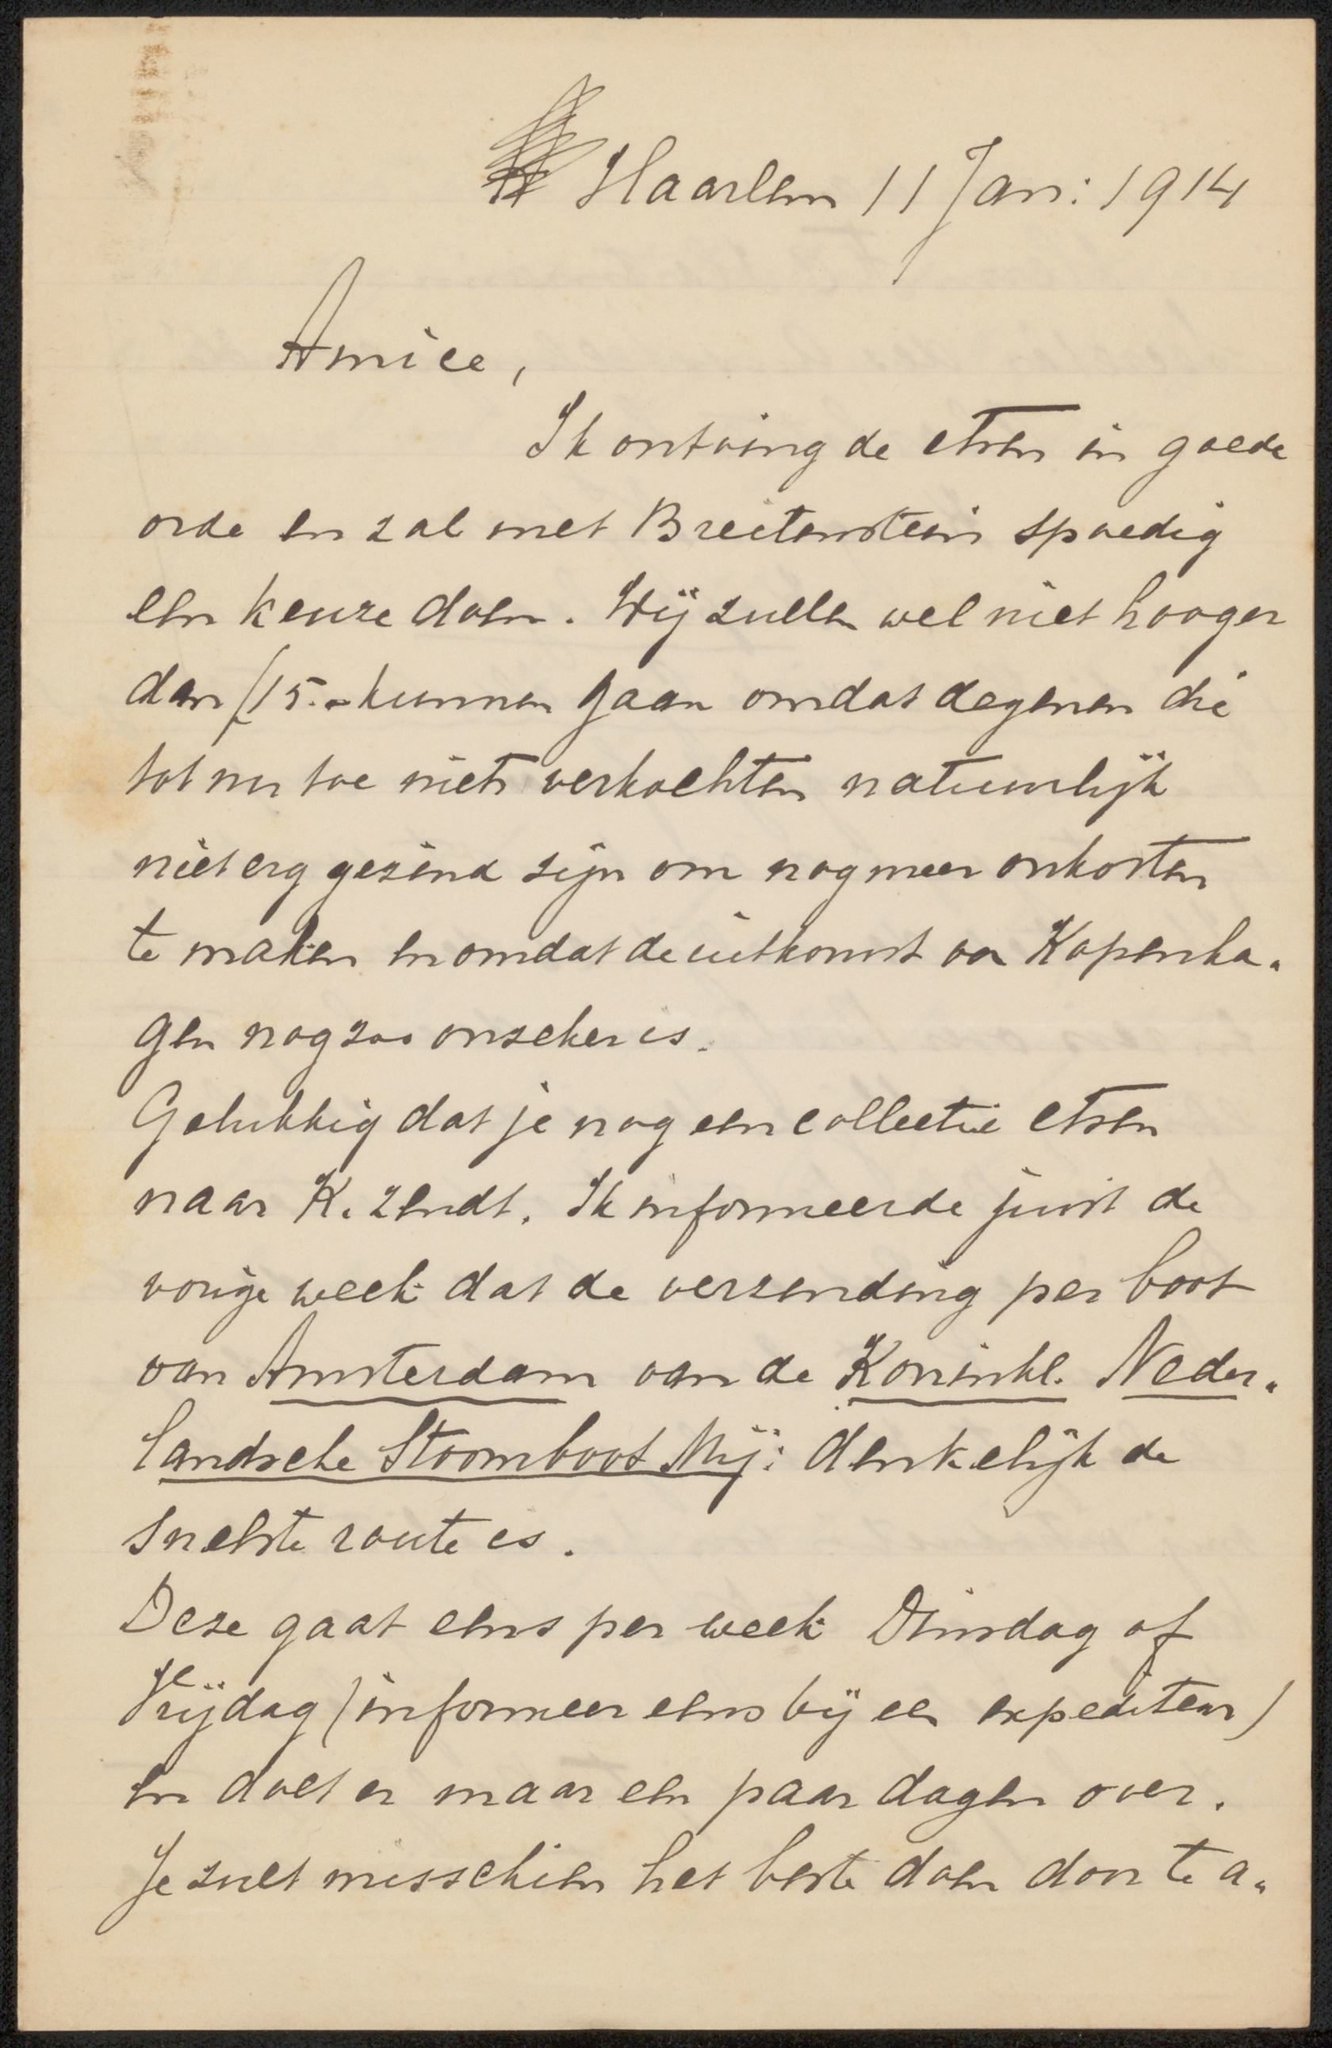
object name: letter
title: Brief aan Philip Zilcken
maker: anton l. koster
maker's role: draughtsman, painter, print maker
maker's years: 1859-1937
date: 1913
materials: ink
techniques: pen, writing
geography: haarlem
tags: willy sluiter, philip zilcken, the graphic arts, travelling; tourism, exhibition ~ art, ghent, copenhagen (city), berlin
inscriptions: collector's mark: ‘RPK’